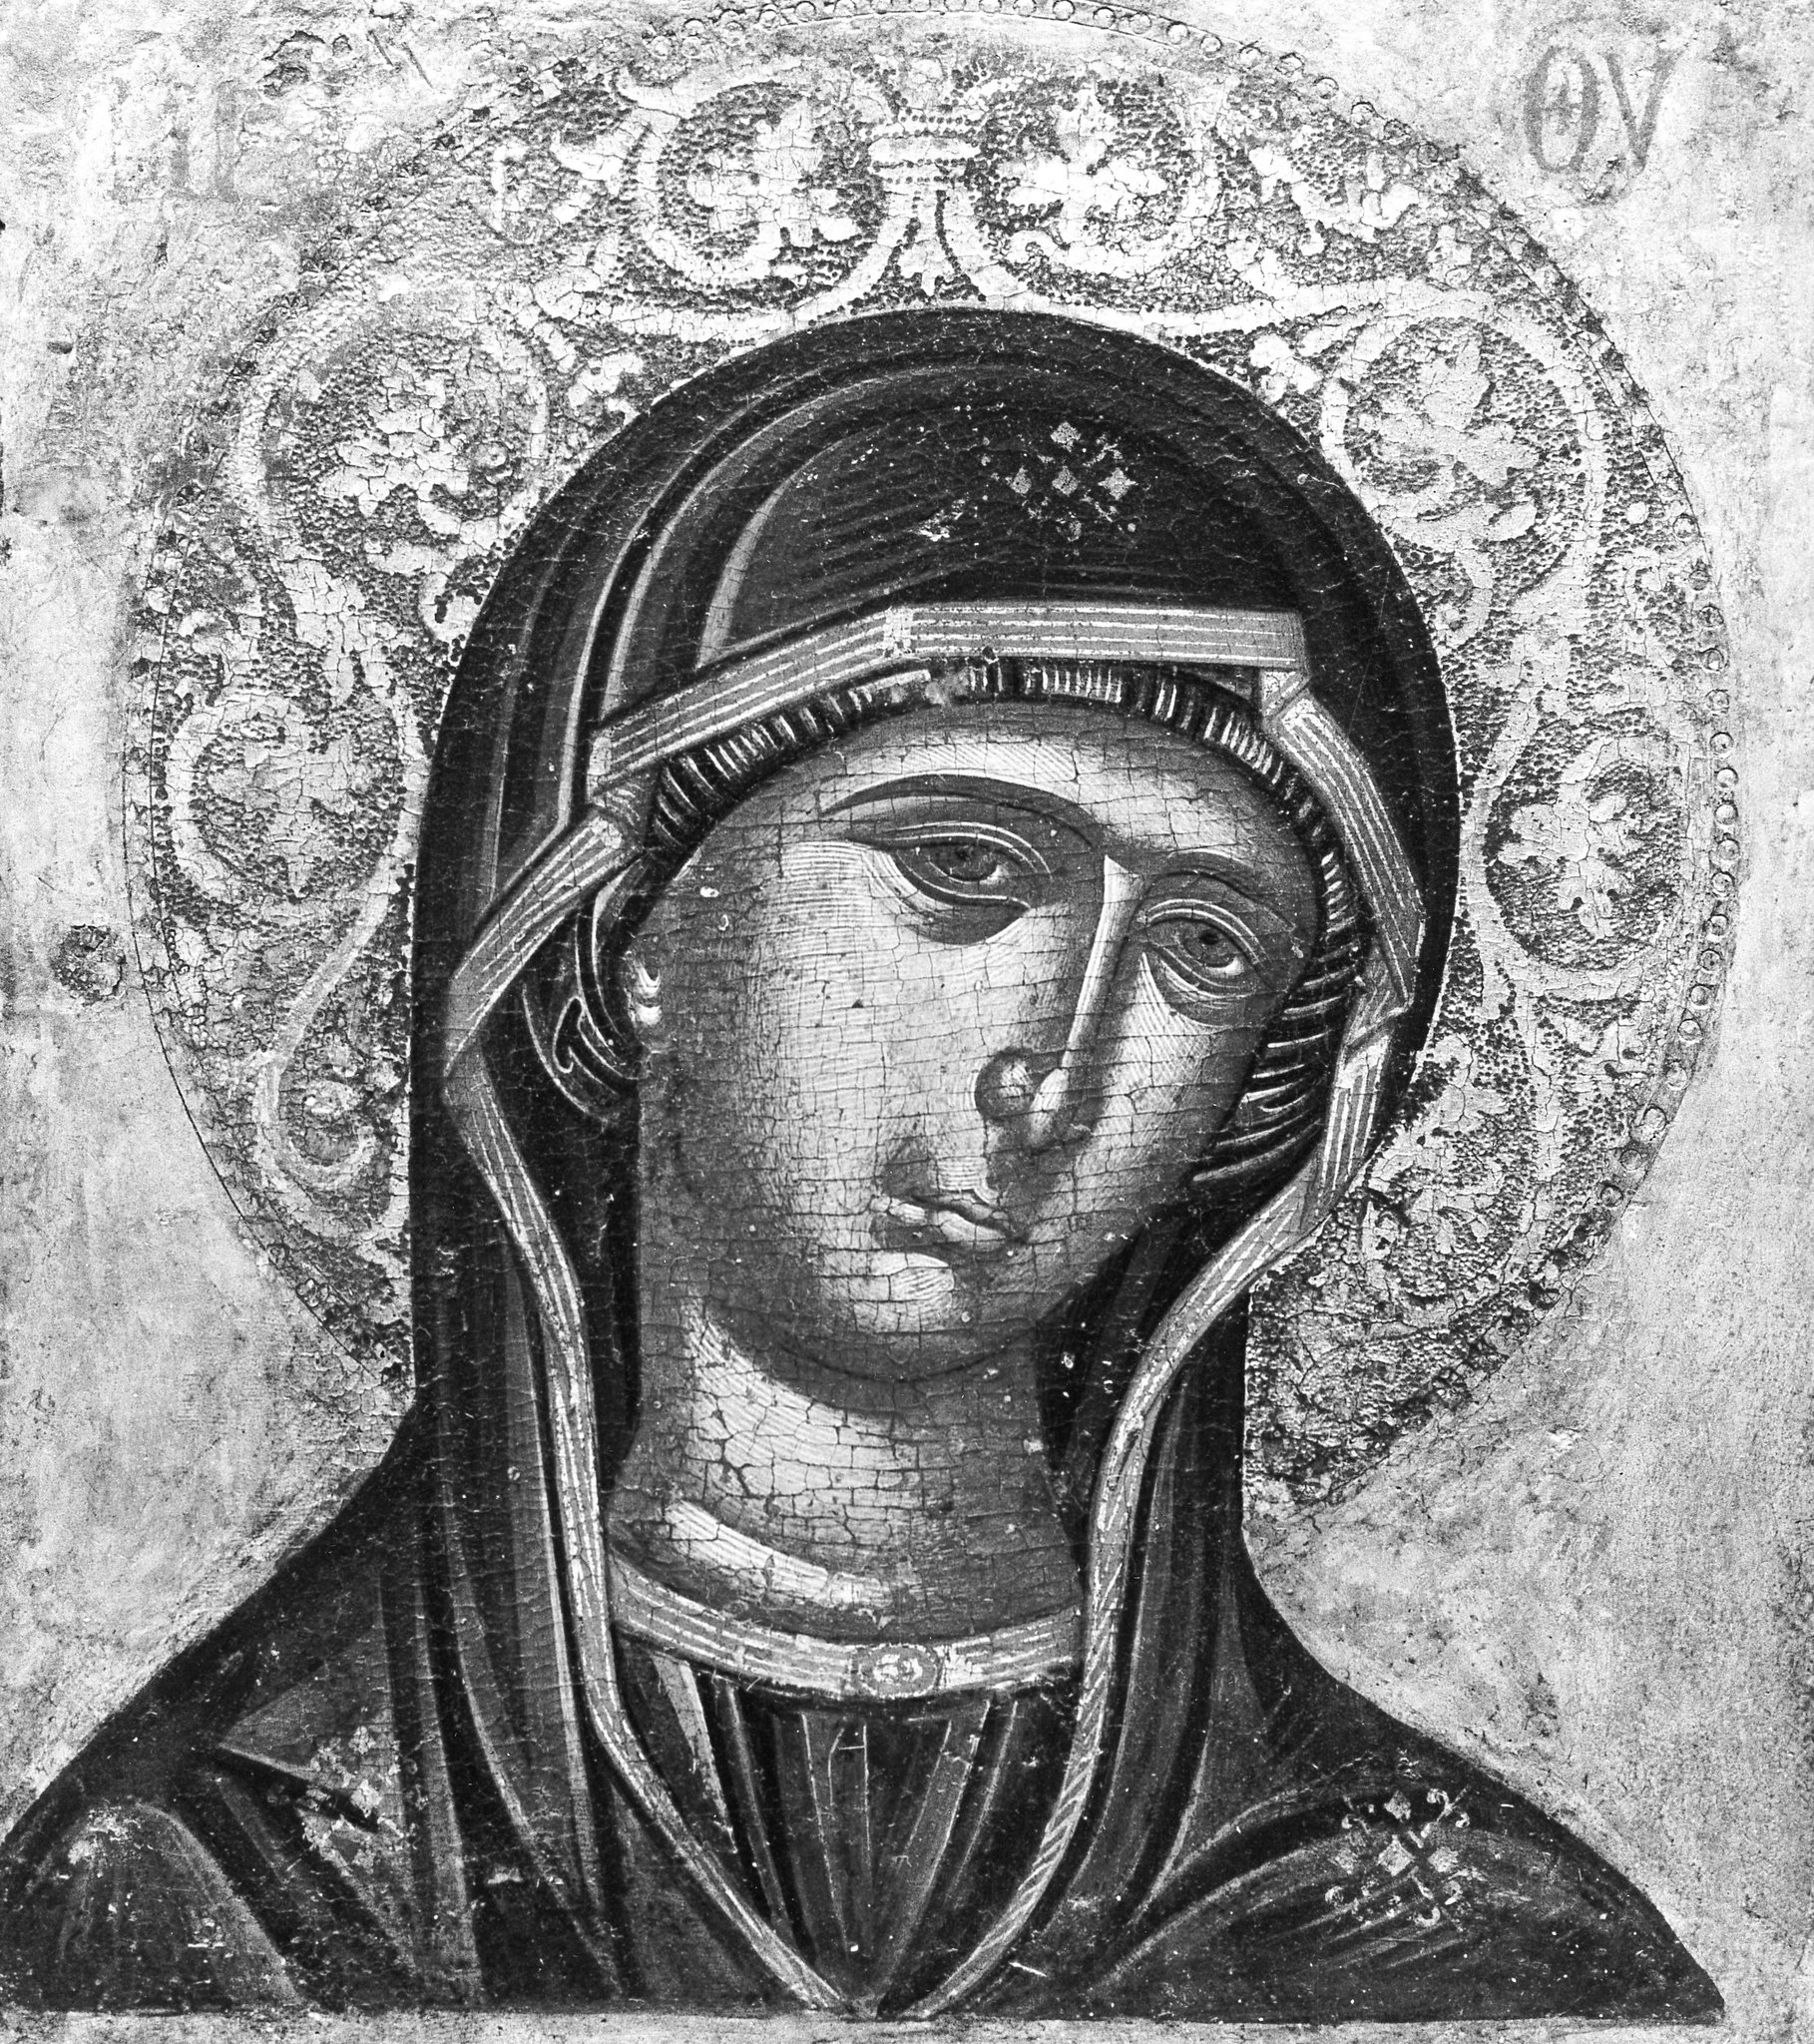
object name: painting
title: Head of the Virgin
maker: emmanuel tzanès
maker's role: artist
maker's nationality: greek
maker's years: 1636-1690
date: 1636-1690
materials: gold leaf, paint, wood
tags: virgin mary